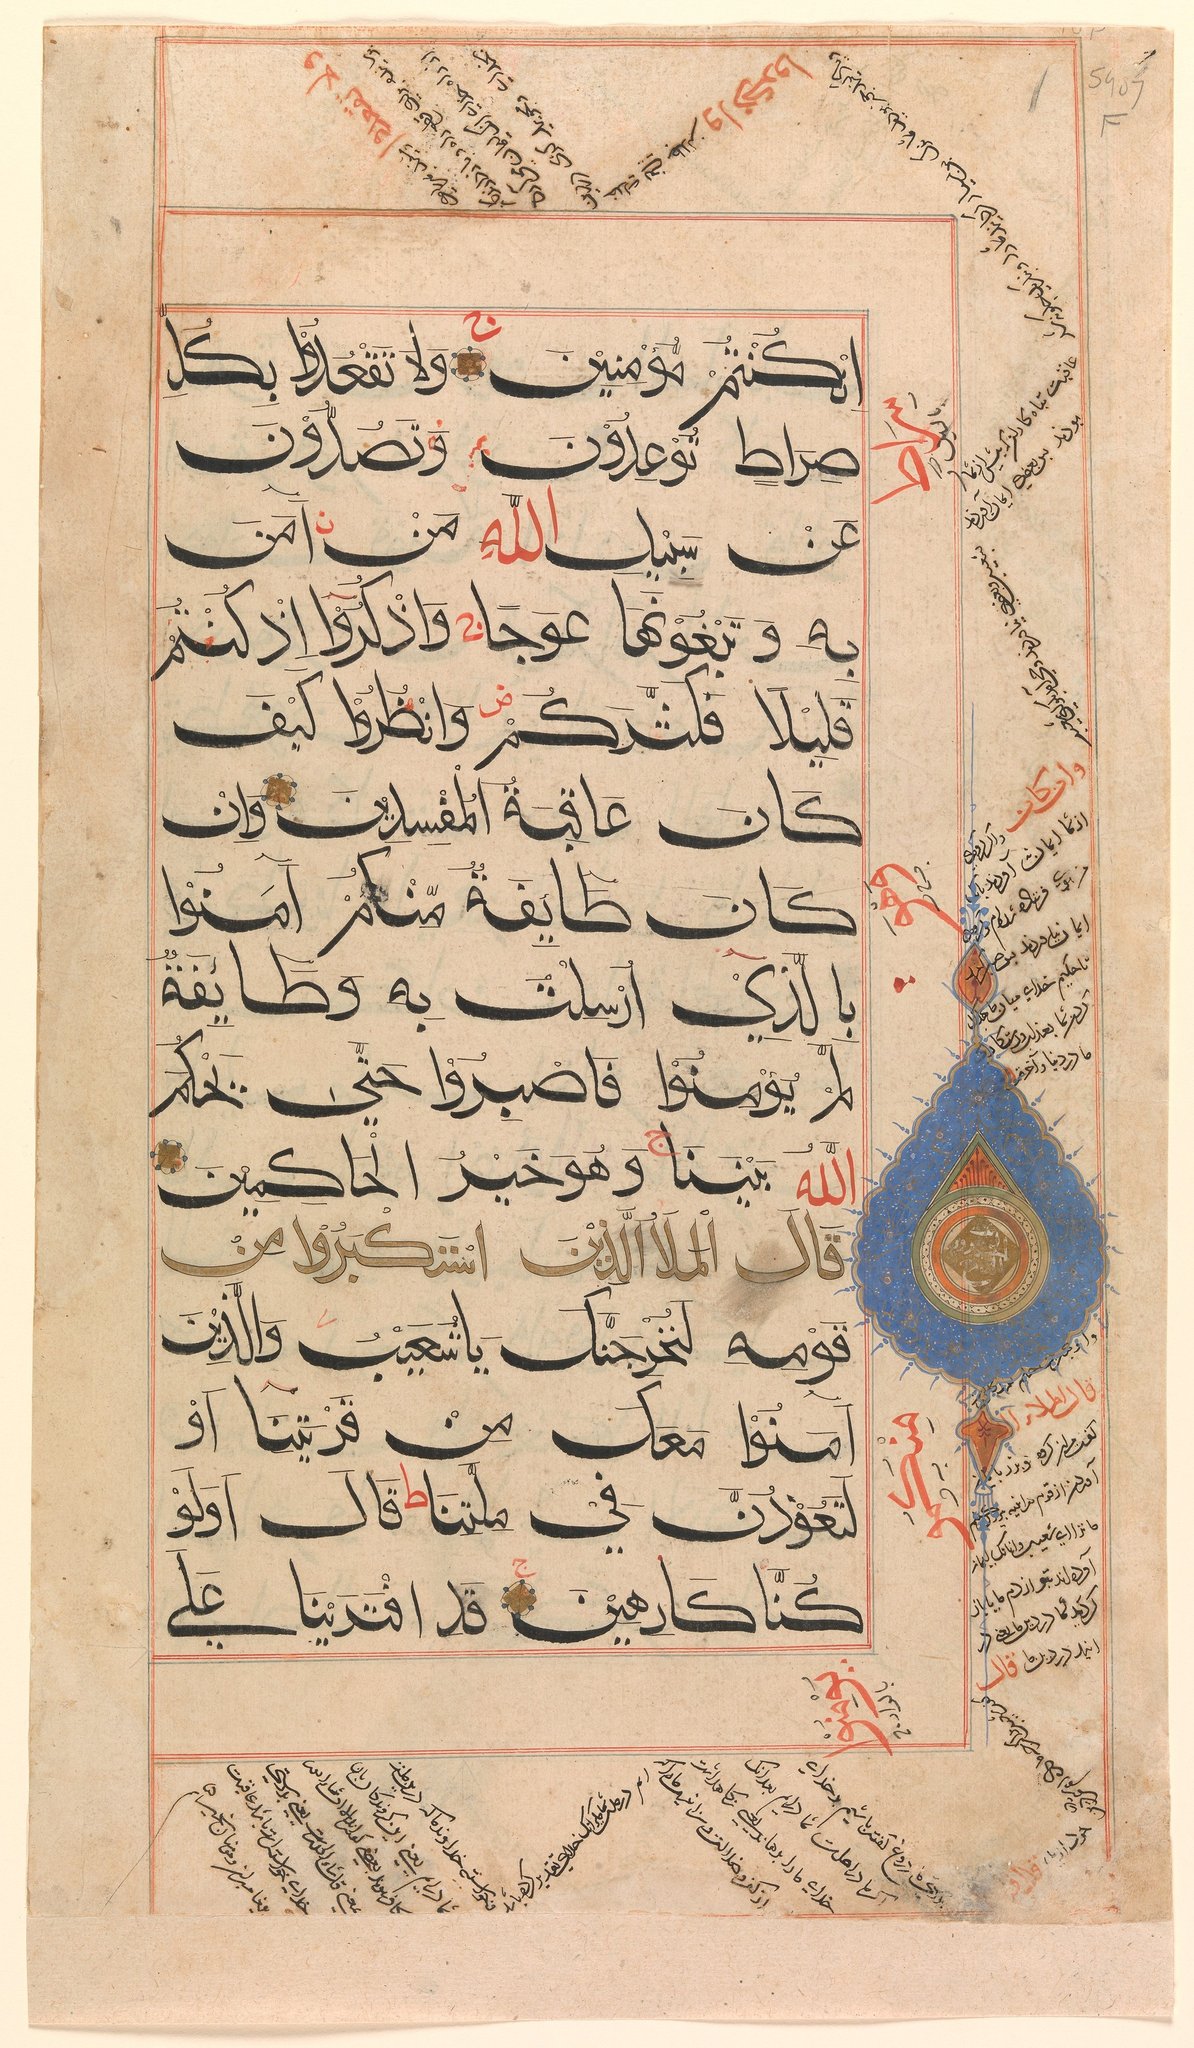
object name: folio from a non illustrated manuscript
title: Folio from a Qur'an Manuscript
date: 1401-1500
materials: gold, ink, paper, watercolor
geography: india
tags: qur'an,calligraphy